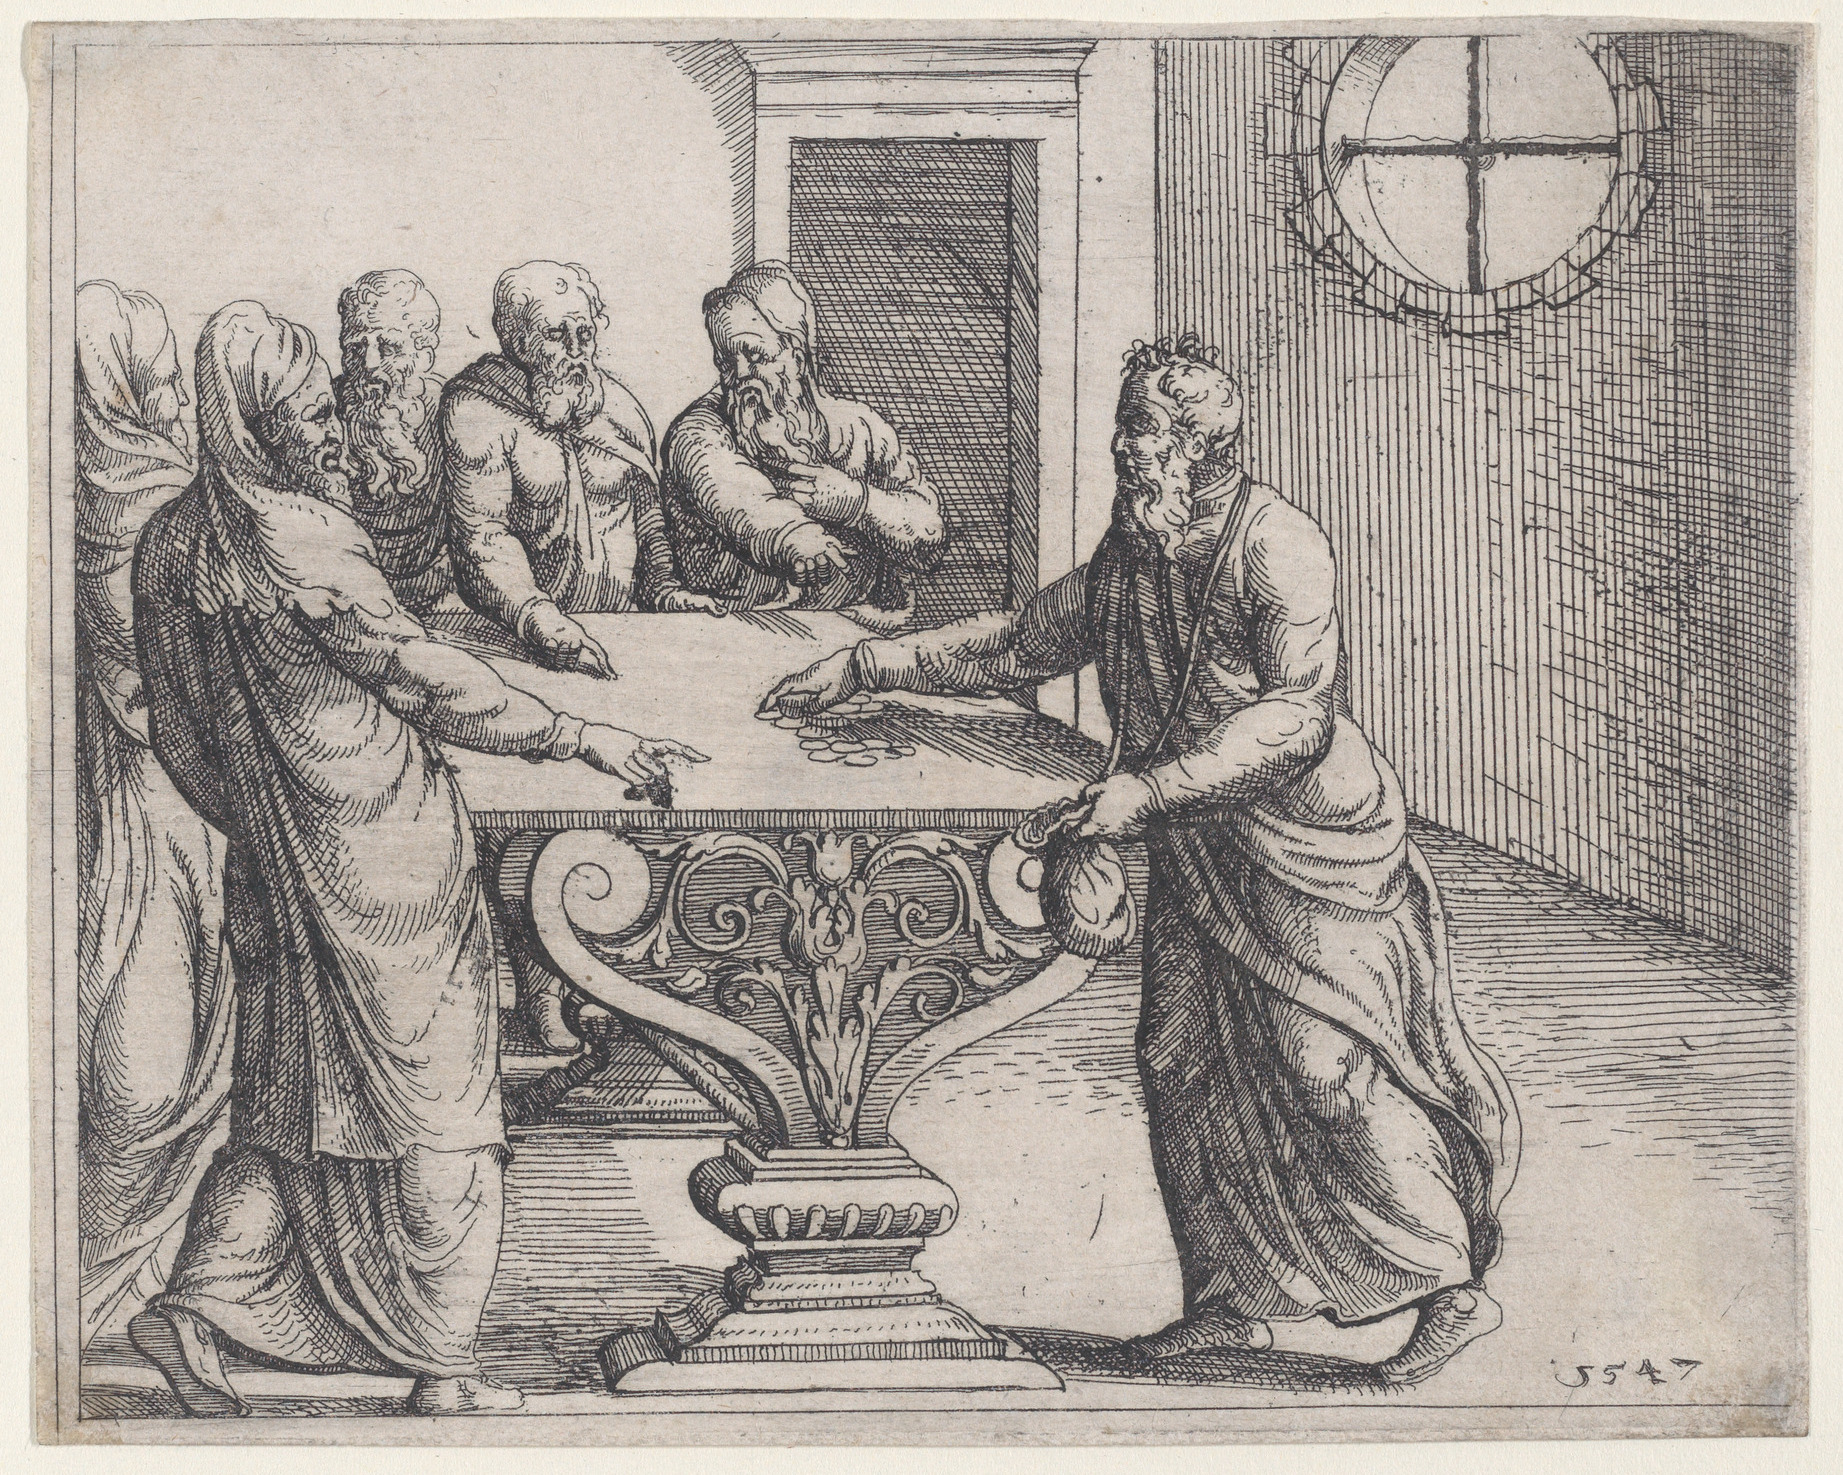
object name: print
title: Judas Receiving the Wages of His Treason, from Old and New Testaments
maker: augustin hirschvogel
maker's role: artist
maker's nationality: german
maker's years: 1503-1553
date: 1547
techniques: etching